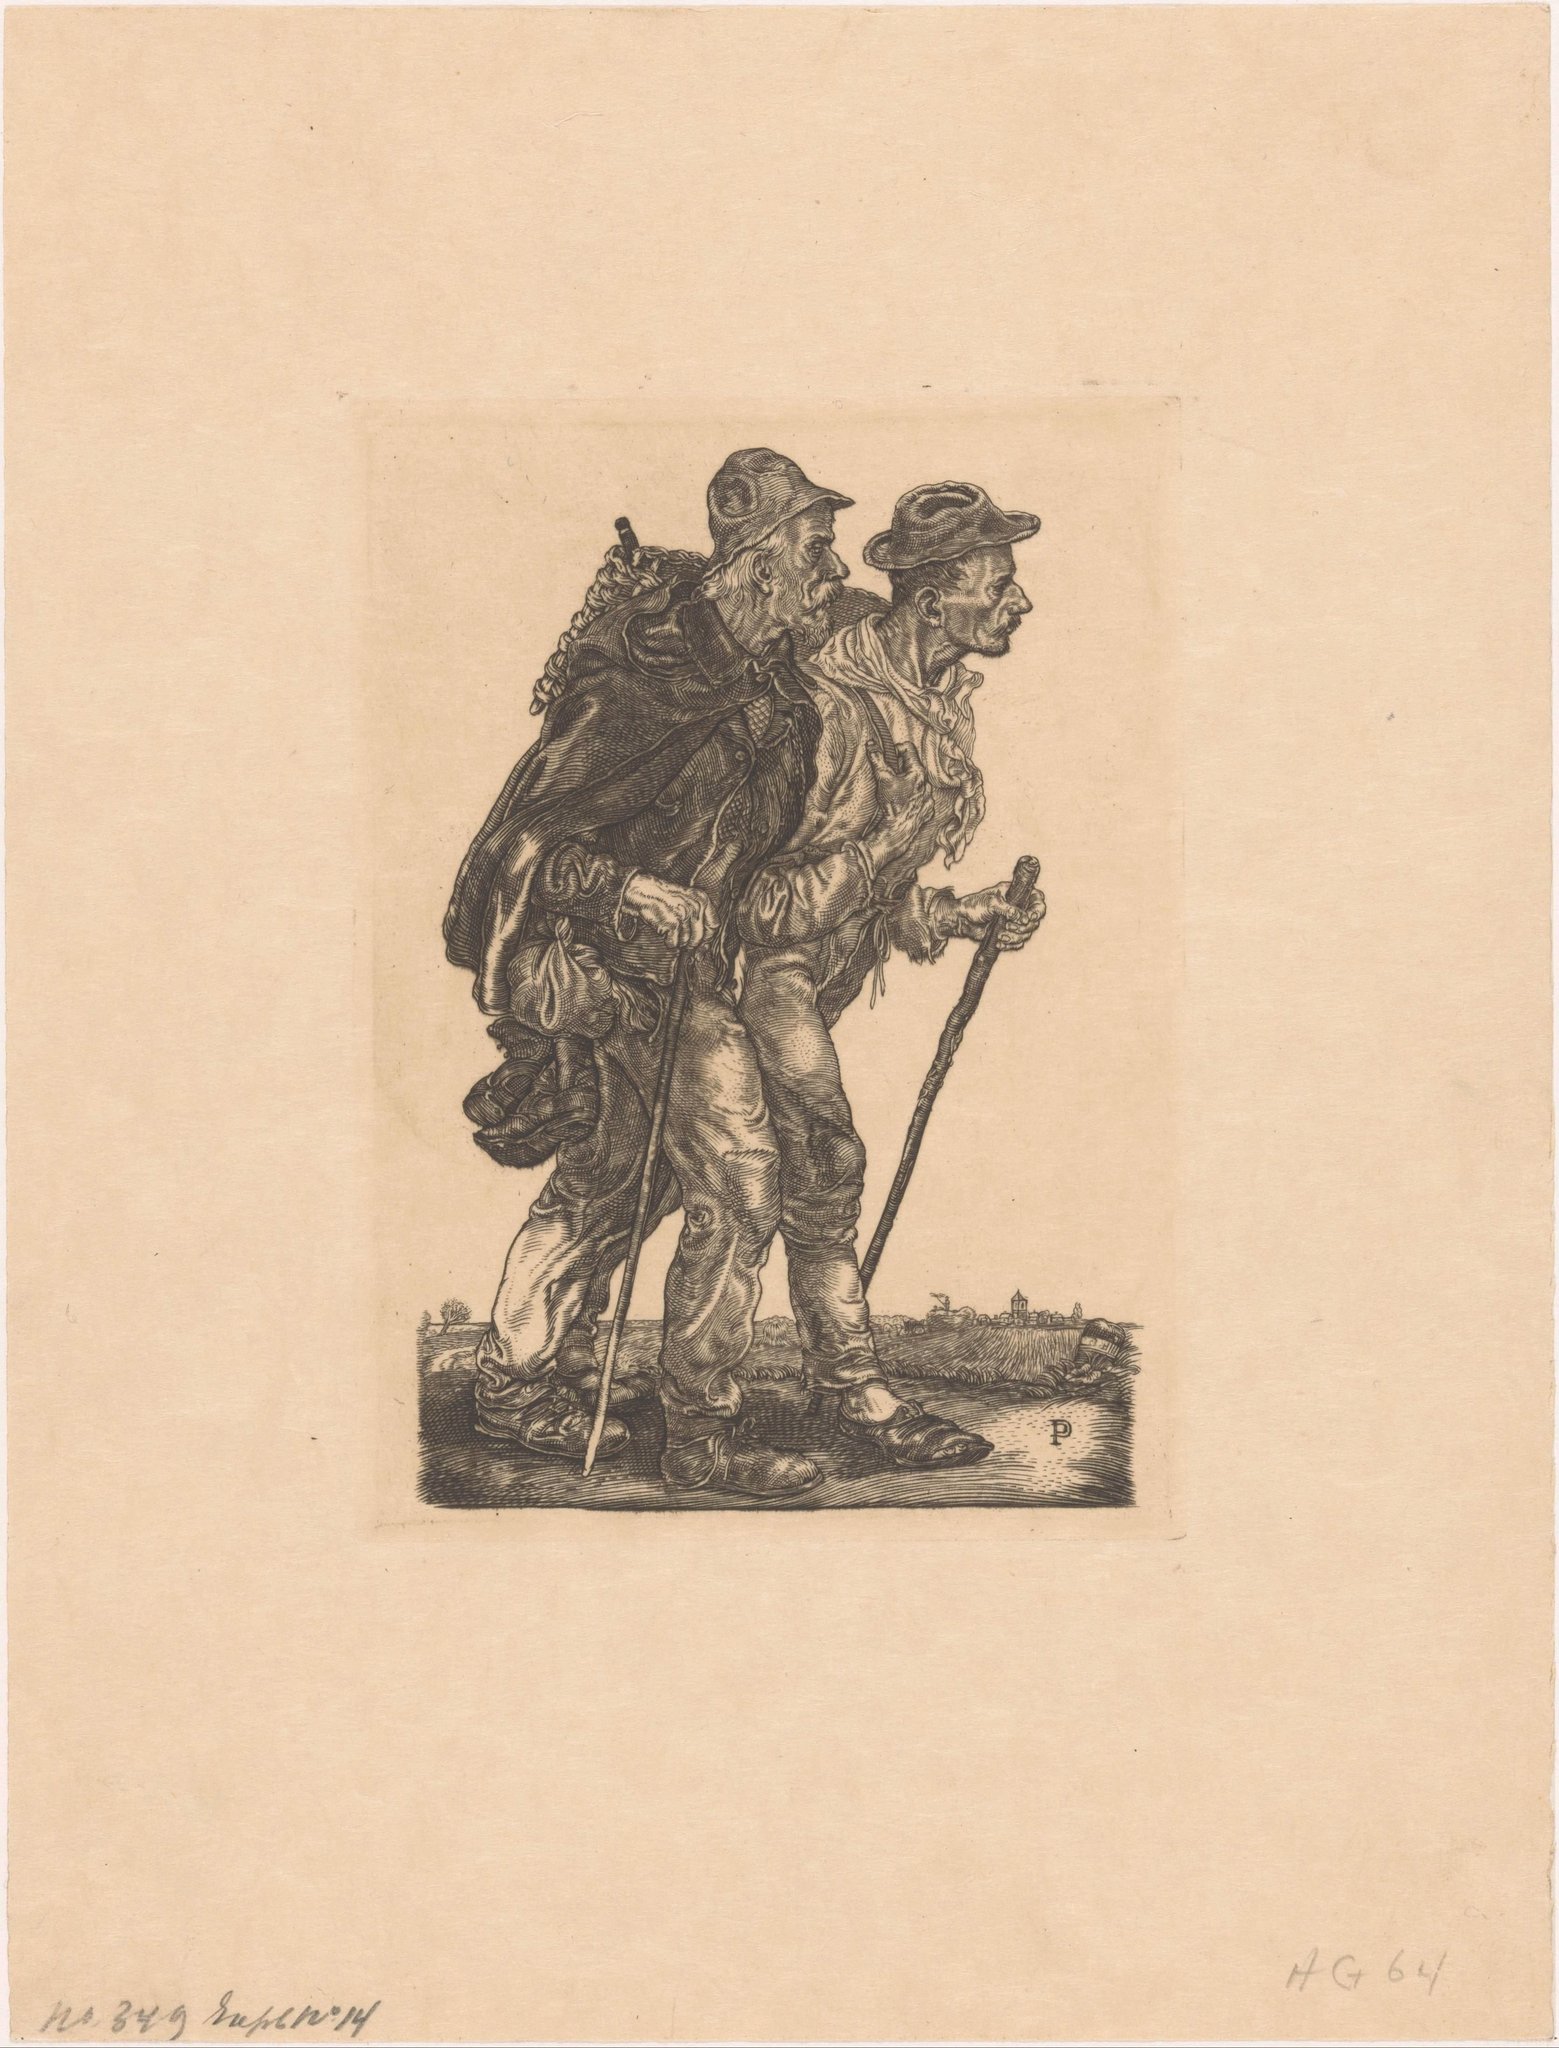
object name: print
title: Bedelaars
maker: pieter dupont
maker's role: draughtsman, print maker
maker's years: 1870-1911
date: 1908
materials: paper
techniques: engraving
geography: hilversum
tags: walking-stick, staff, beggar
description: Twee wandelende mannen met hoed en wandelstok. Rechts op de achtergrond een kerktoren.